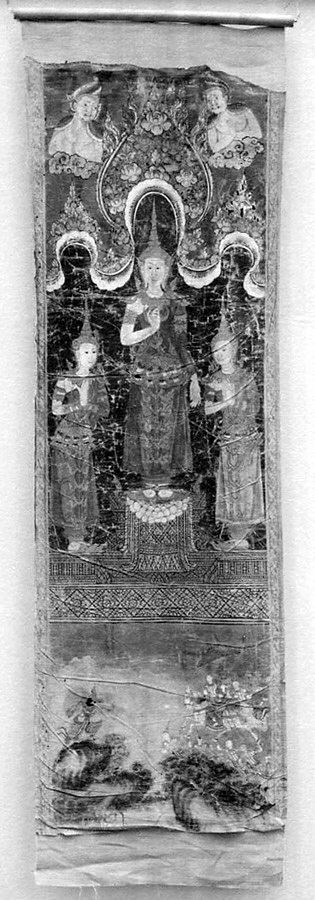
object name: hanging scroll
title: Buddha with Two Attendants (?)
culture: thai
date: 1601-1800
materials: canvas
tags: buddha